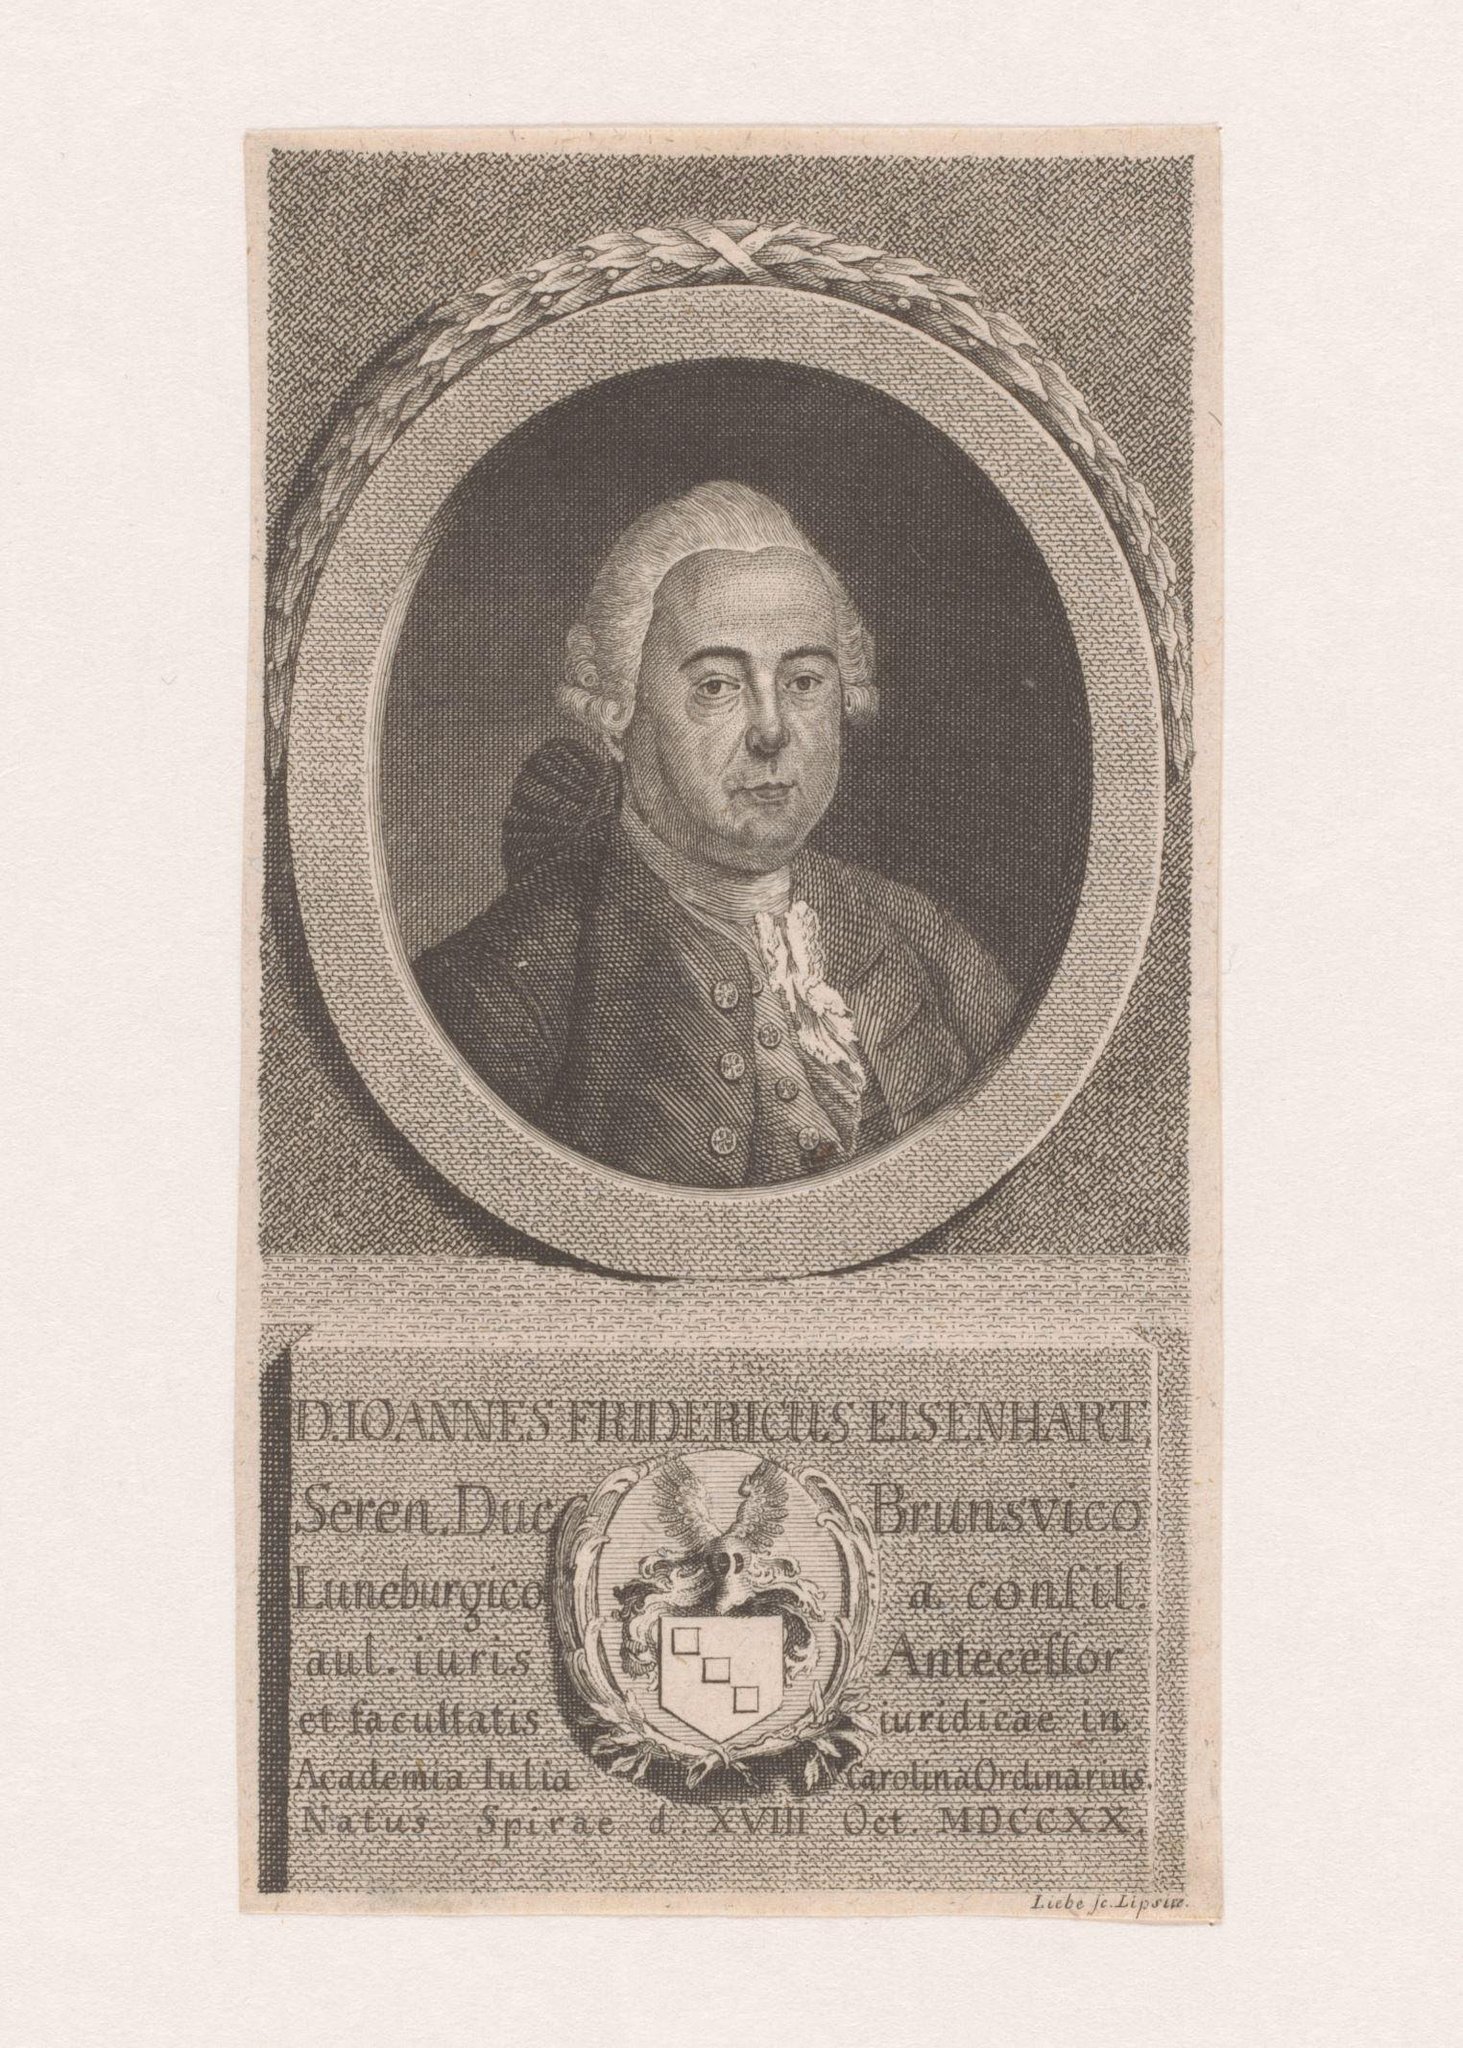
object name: print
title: Portret van Johann Friedrich Eisenhart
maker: gottlob august liebe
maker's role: draughtsman, print maker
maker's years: 1746-1819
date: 1756-1819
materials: paper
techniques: engraving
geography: leipzig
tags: further education (+ portrait of teacher, professor), historical persons, lawyer, attorney at law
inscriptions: collector's mark: Lugt 2228